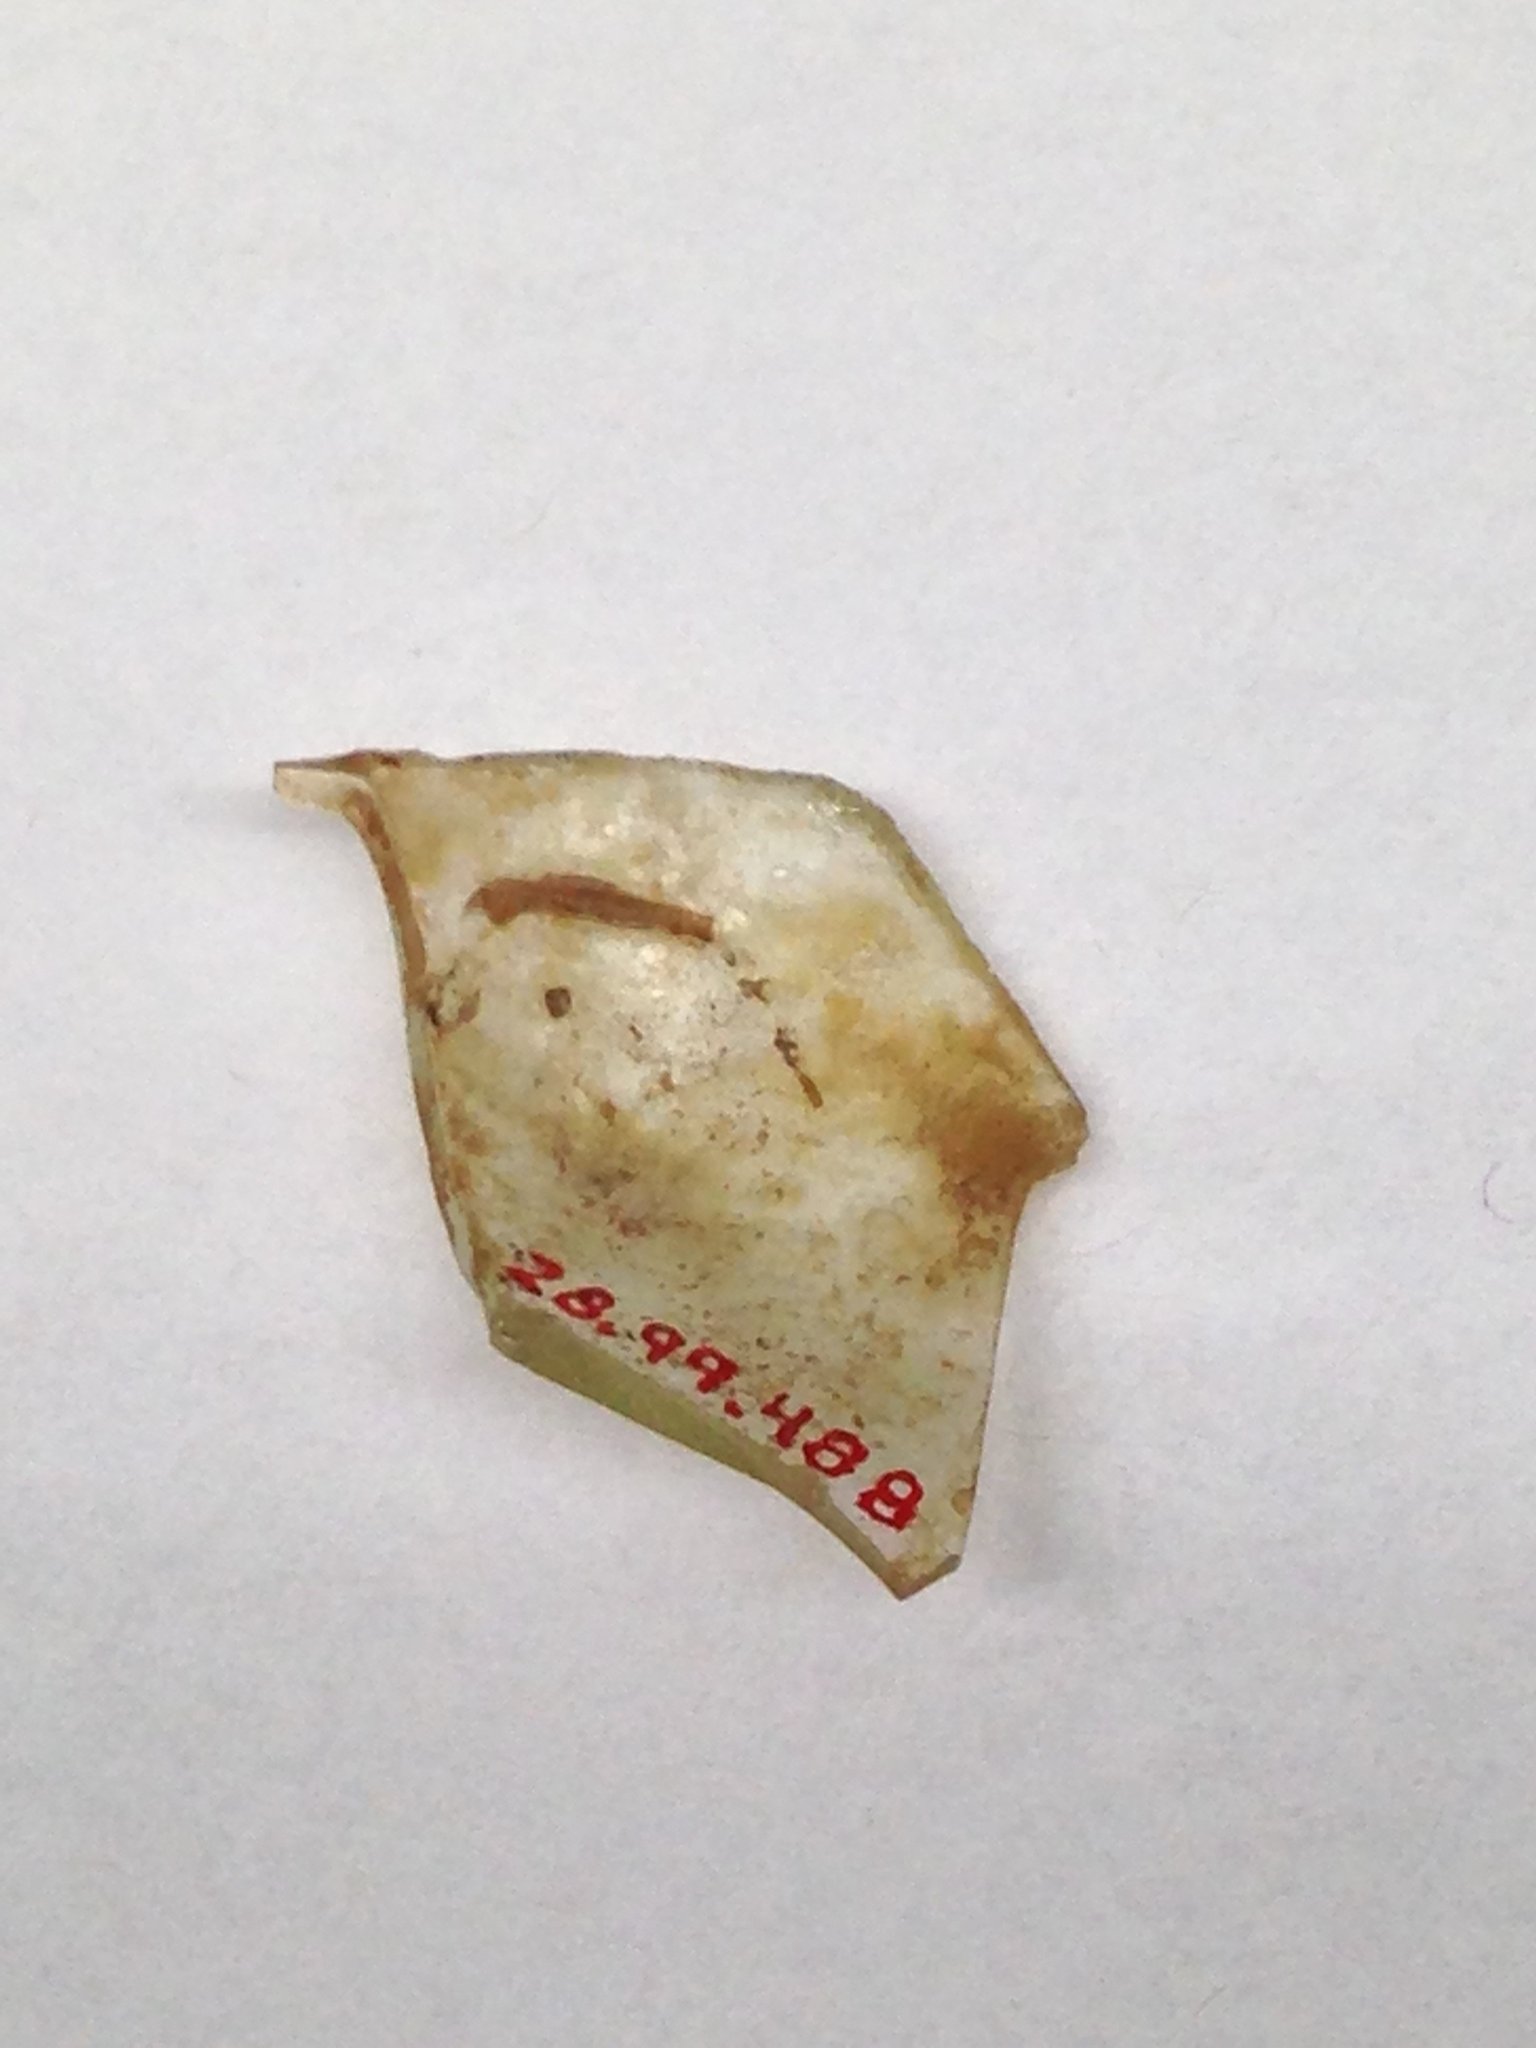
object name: fragment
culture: european or middle eastern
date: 1150-1250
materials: ceramic, glass